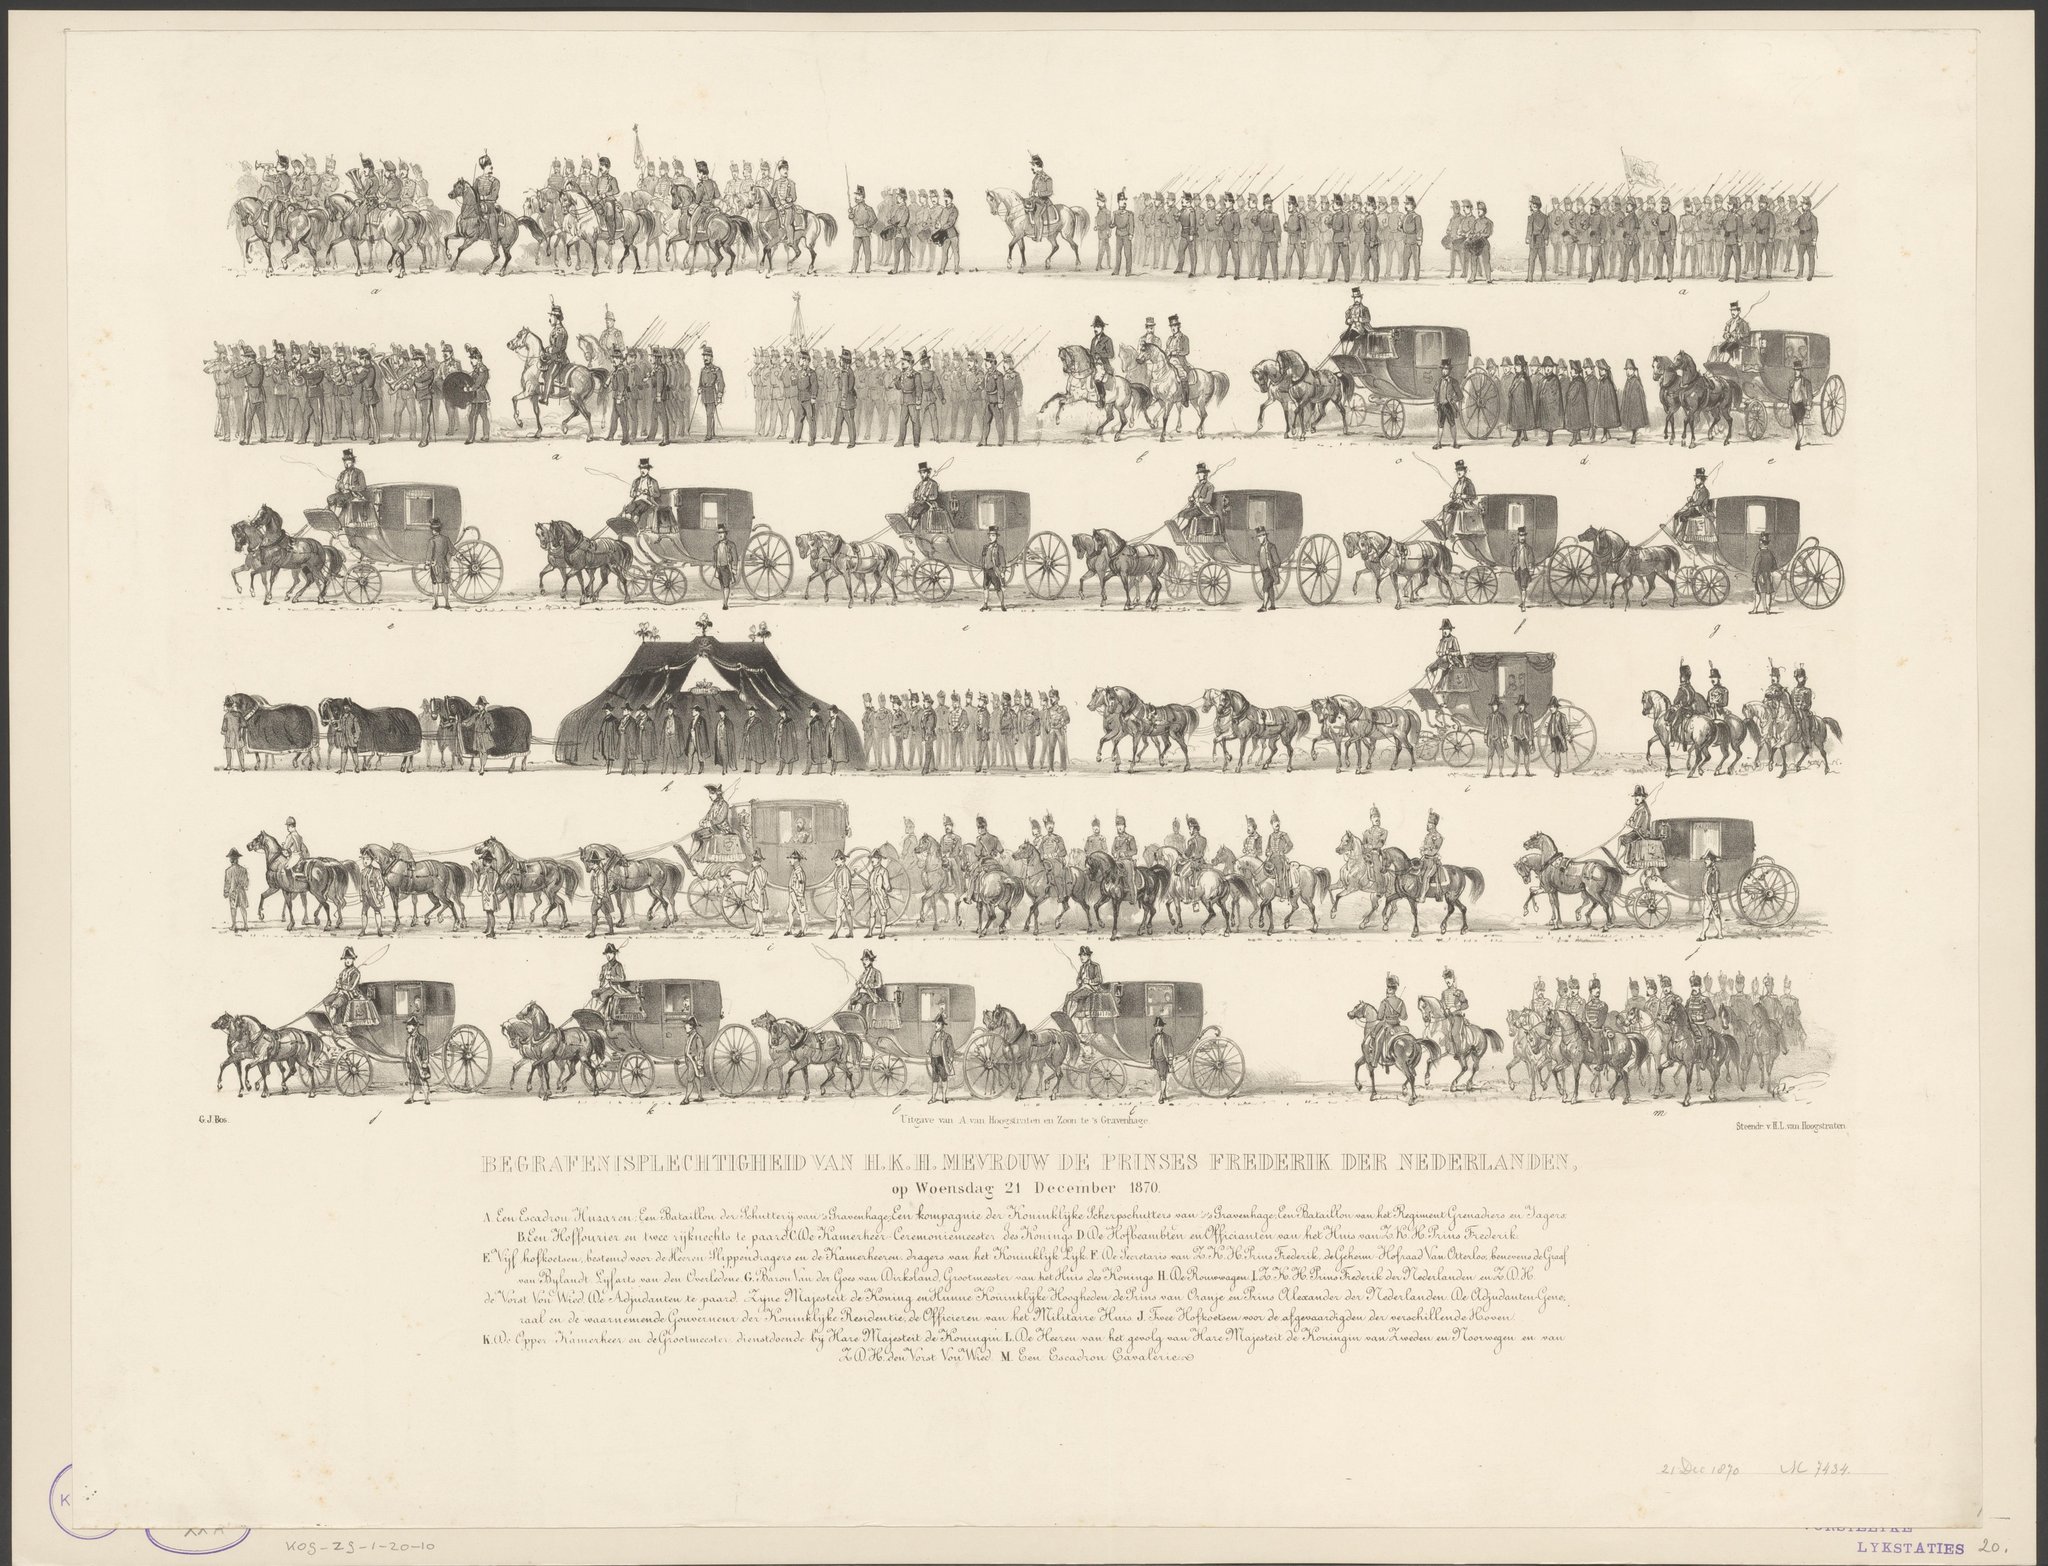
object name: print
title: Begrafenisstoet van Louise van Pruisen, 1870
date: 1870-1871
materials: paper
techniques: lithograph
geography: the hague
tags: cortege, funeral procession, delft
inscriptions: collector's mark: Lugt 1641, stamp, stamp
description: De begrafenisstoet van prinses Louise van Pruisen, echtgenote van prins Frederik (overleden op 6 december) te Delft op 21 december 1870. De stoet afgebeeld in zes rijen onder elkaar. Onderaan de legenda a-m. Onderwerpsrubrieken binnen de Atlas Zeden en Gewoonten: Zeden en Gewoonten in Engeren Zin, Des menschen beging, midden en einde, Vorstelijke lijkstaties.